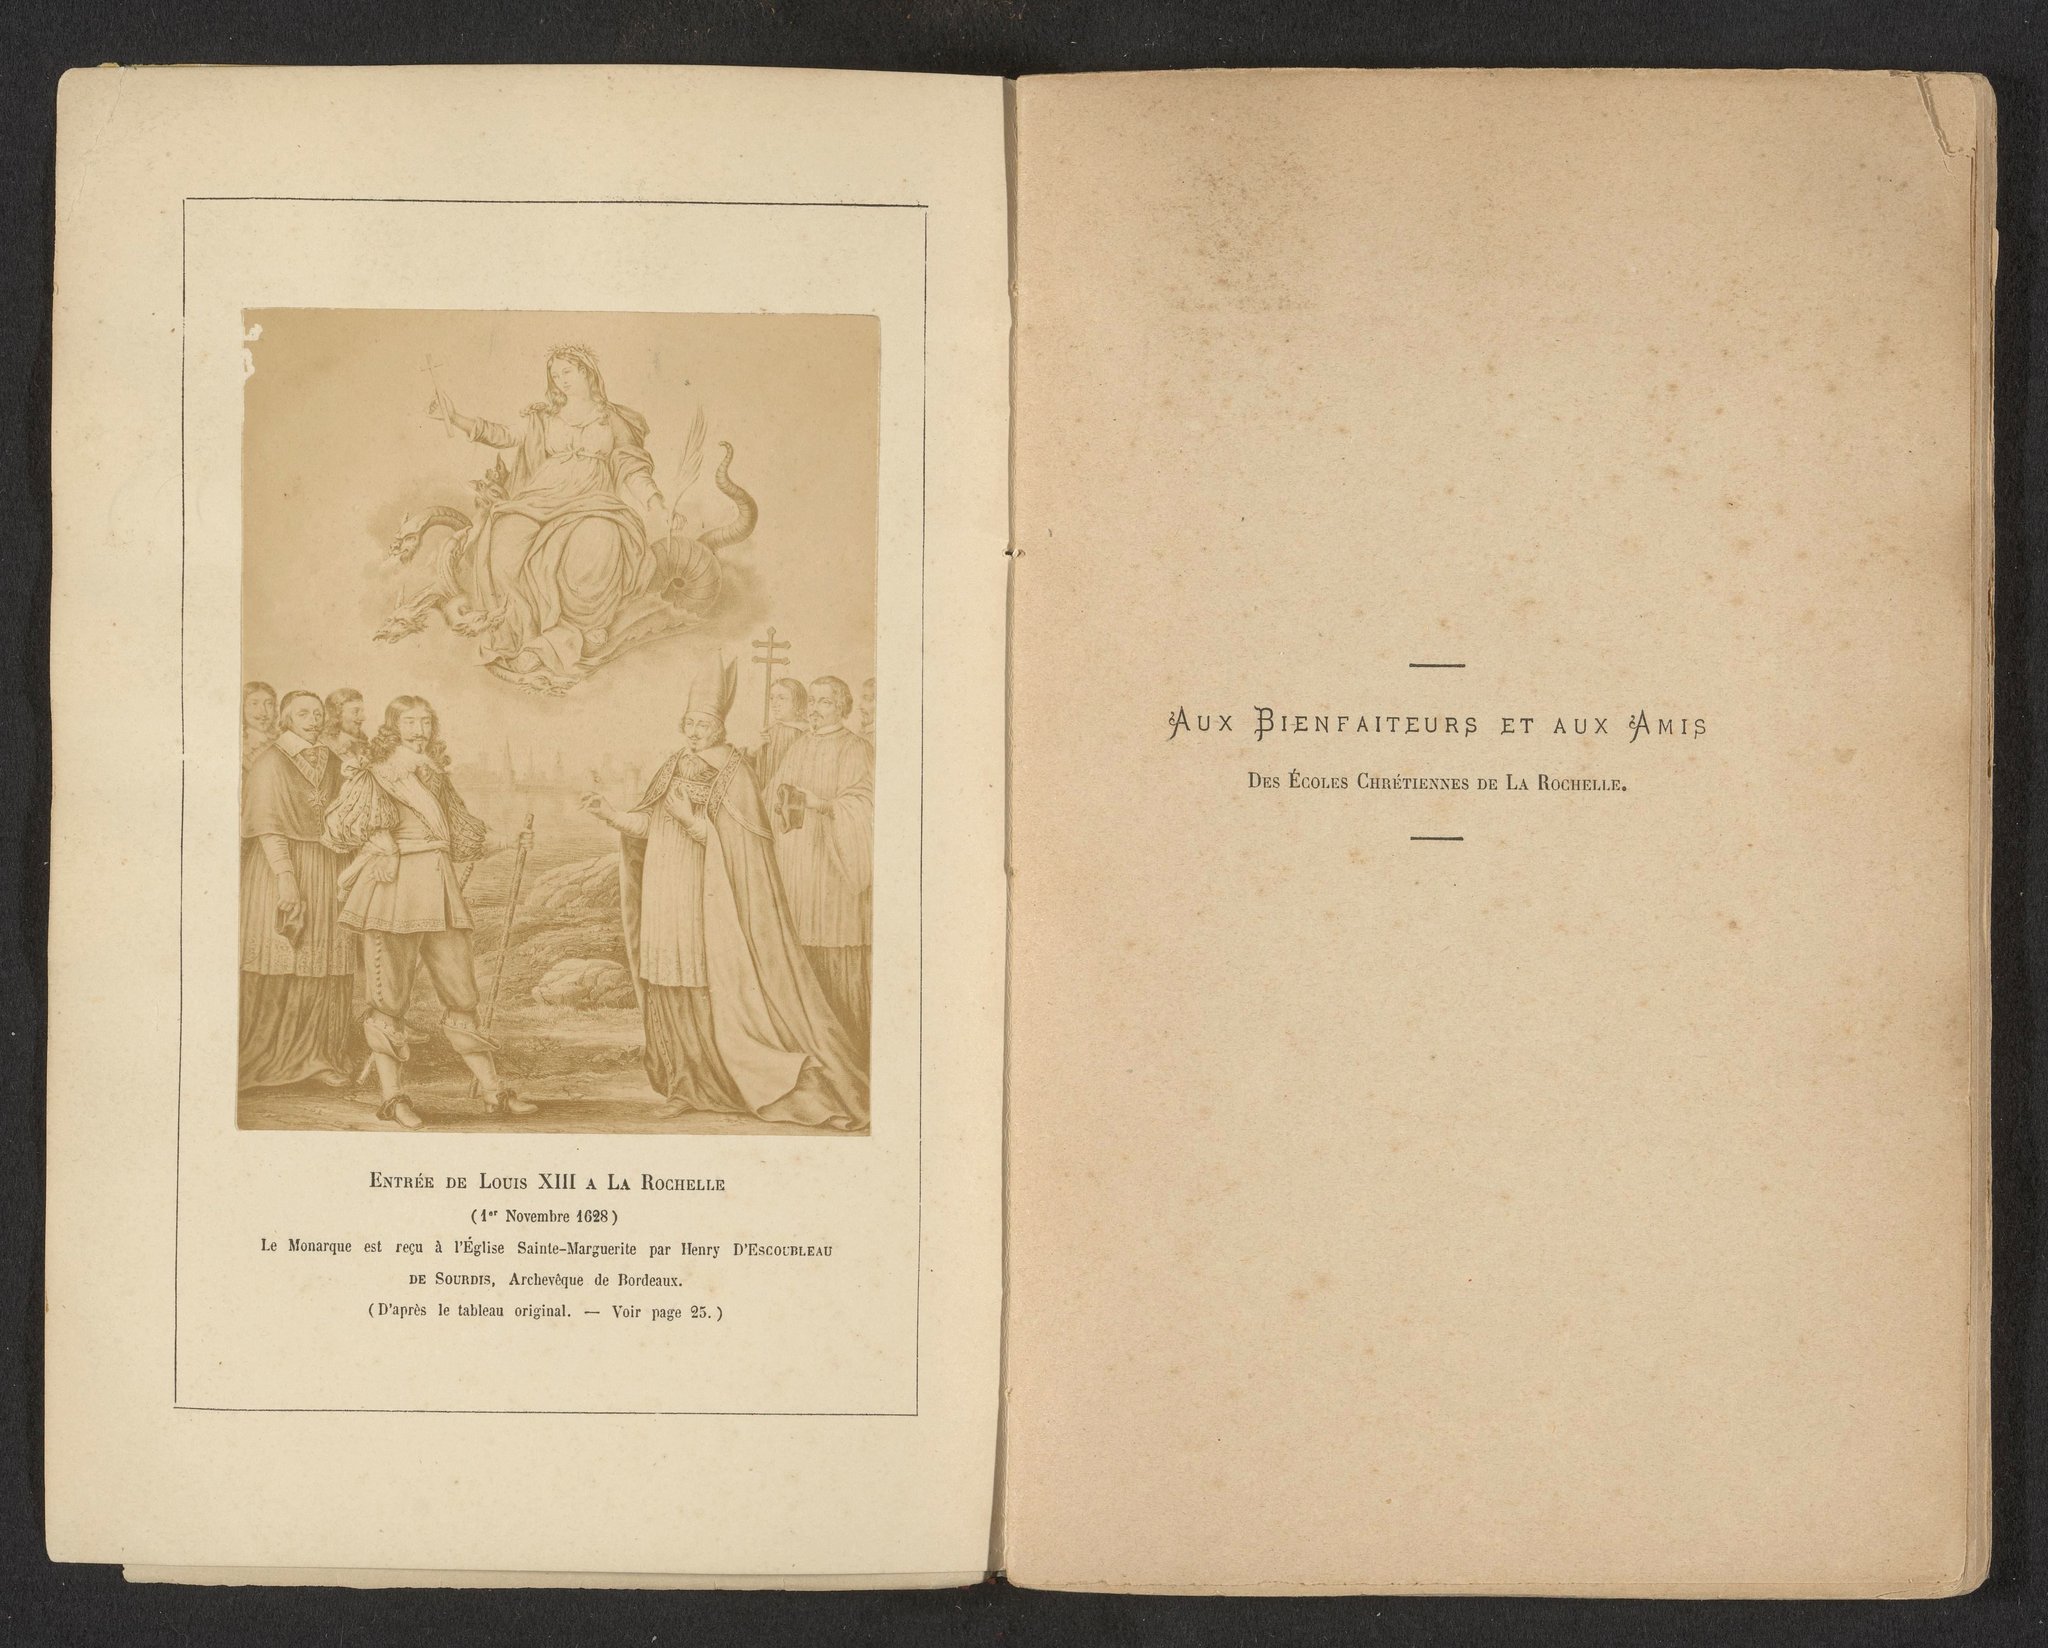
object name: reproduction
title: Entrée de Louis XIII a La Rochelle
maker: Anonymous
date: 1871-1881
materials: photographic support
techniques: albumen print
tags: lodewijk xiii (koning van frankrijk), capture of city (after the siege), ruler, sovereign, march into the conquered place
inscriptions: inscription: ‘Le Monarque (...) de Bordeaux.’